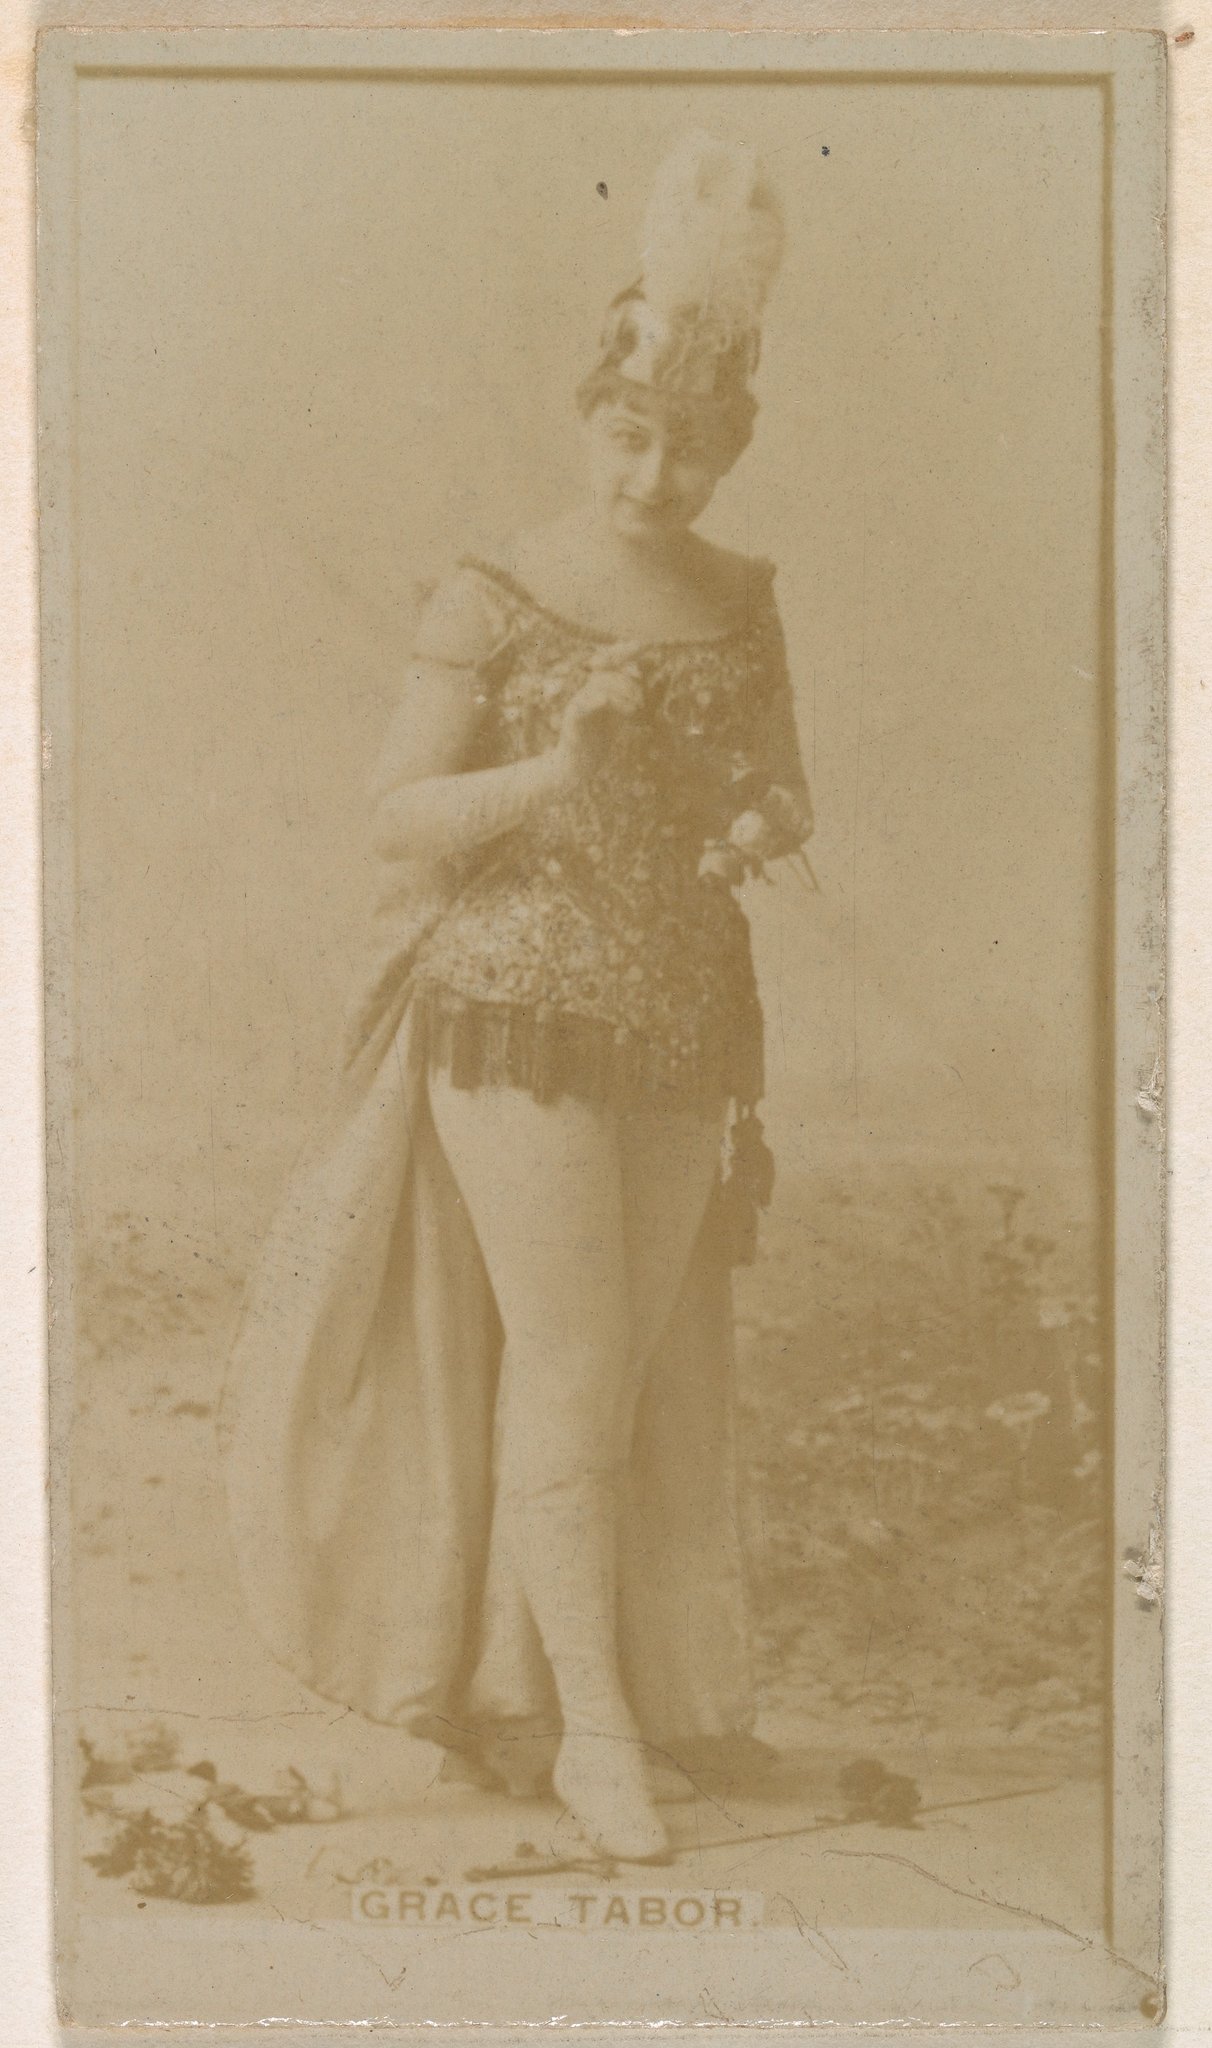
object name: photograph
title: Grace Tabor, from the Actresses series (N245) issued by Kinney Brothers to promote Sweet Caporal Cigarettes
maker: kinney brothers tobacco company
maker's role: publisher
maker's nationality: american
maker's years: 1869-2011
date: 1890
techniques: albumen silver print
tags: portraits,women,actresses